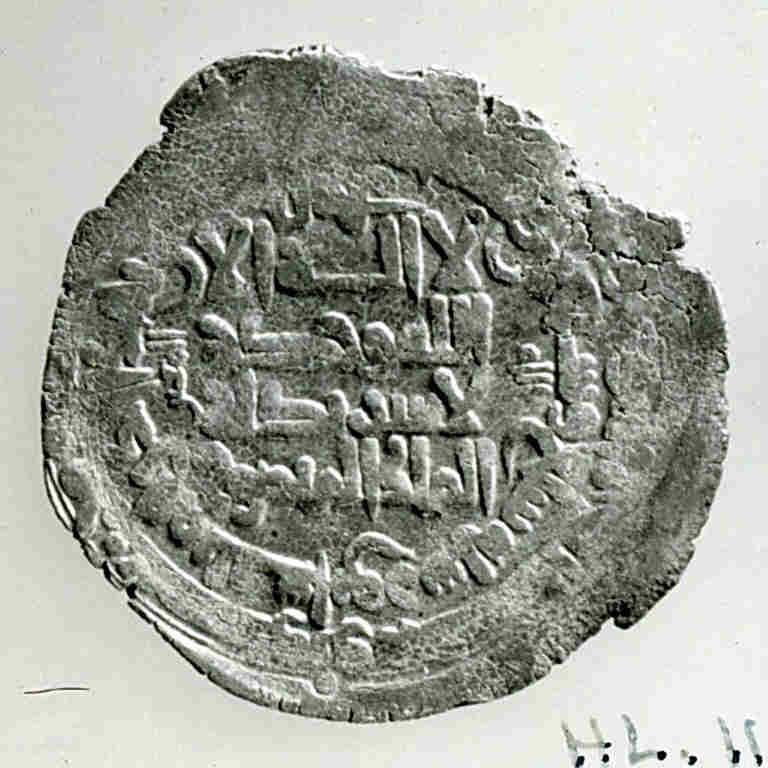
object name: coin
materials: silver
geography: iran